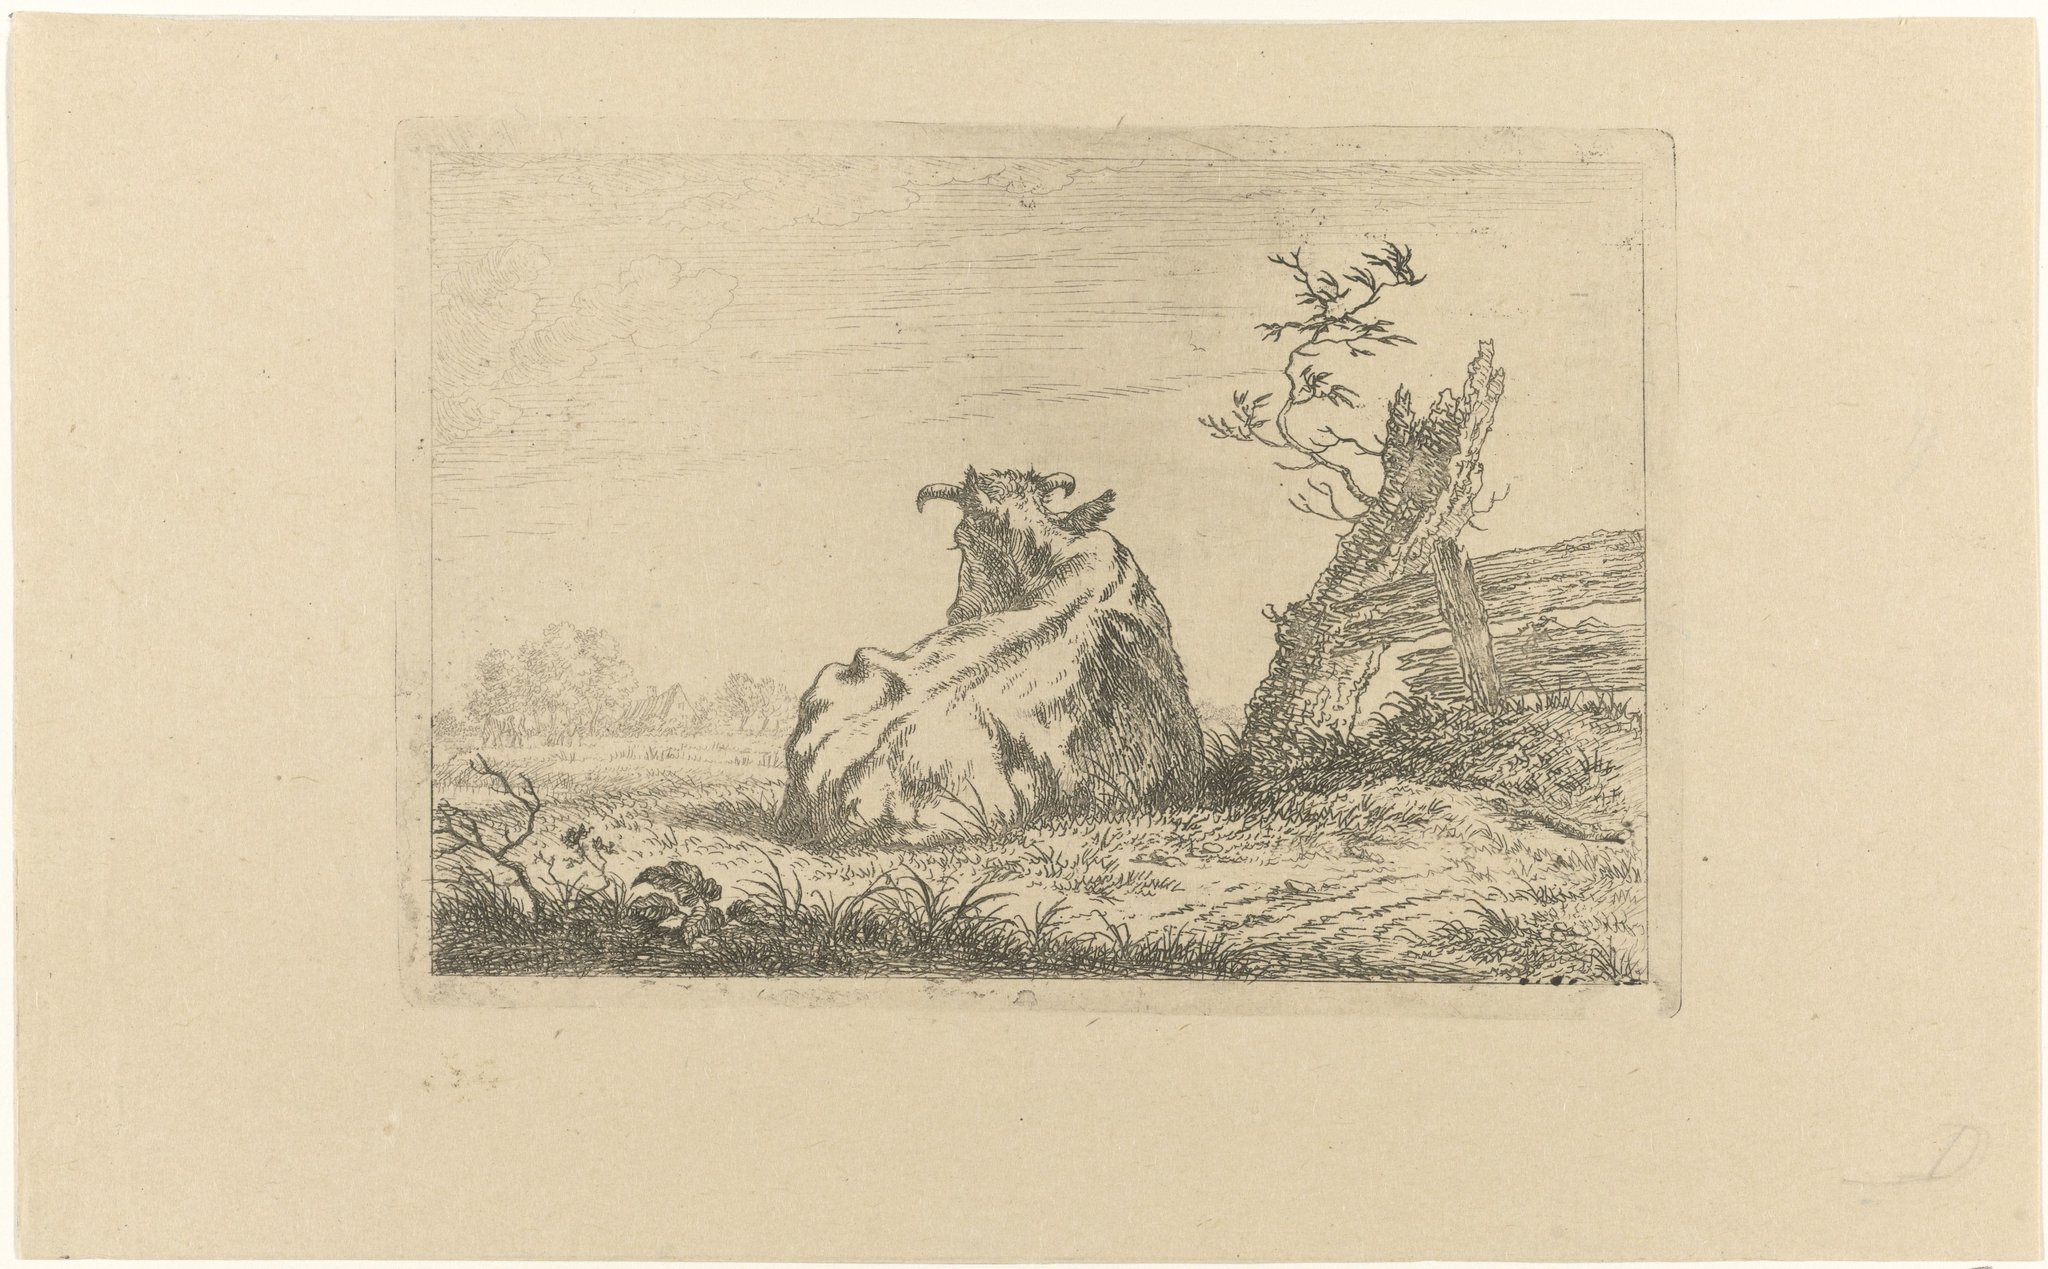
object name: print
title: Weiland met liggende koe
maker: johannes janson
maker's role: draughtsman, painter, print maker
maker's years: 1729-1784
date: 1761-1784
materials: paper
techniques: etching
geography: leiden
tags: cow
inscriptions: collector's mark: Lugt 240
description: Weiland met liggende koe, op de rug gezien. Rechts een hek, boomstronk en tak. Prent uit een serie met landschappen met vee.